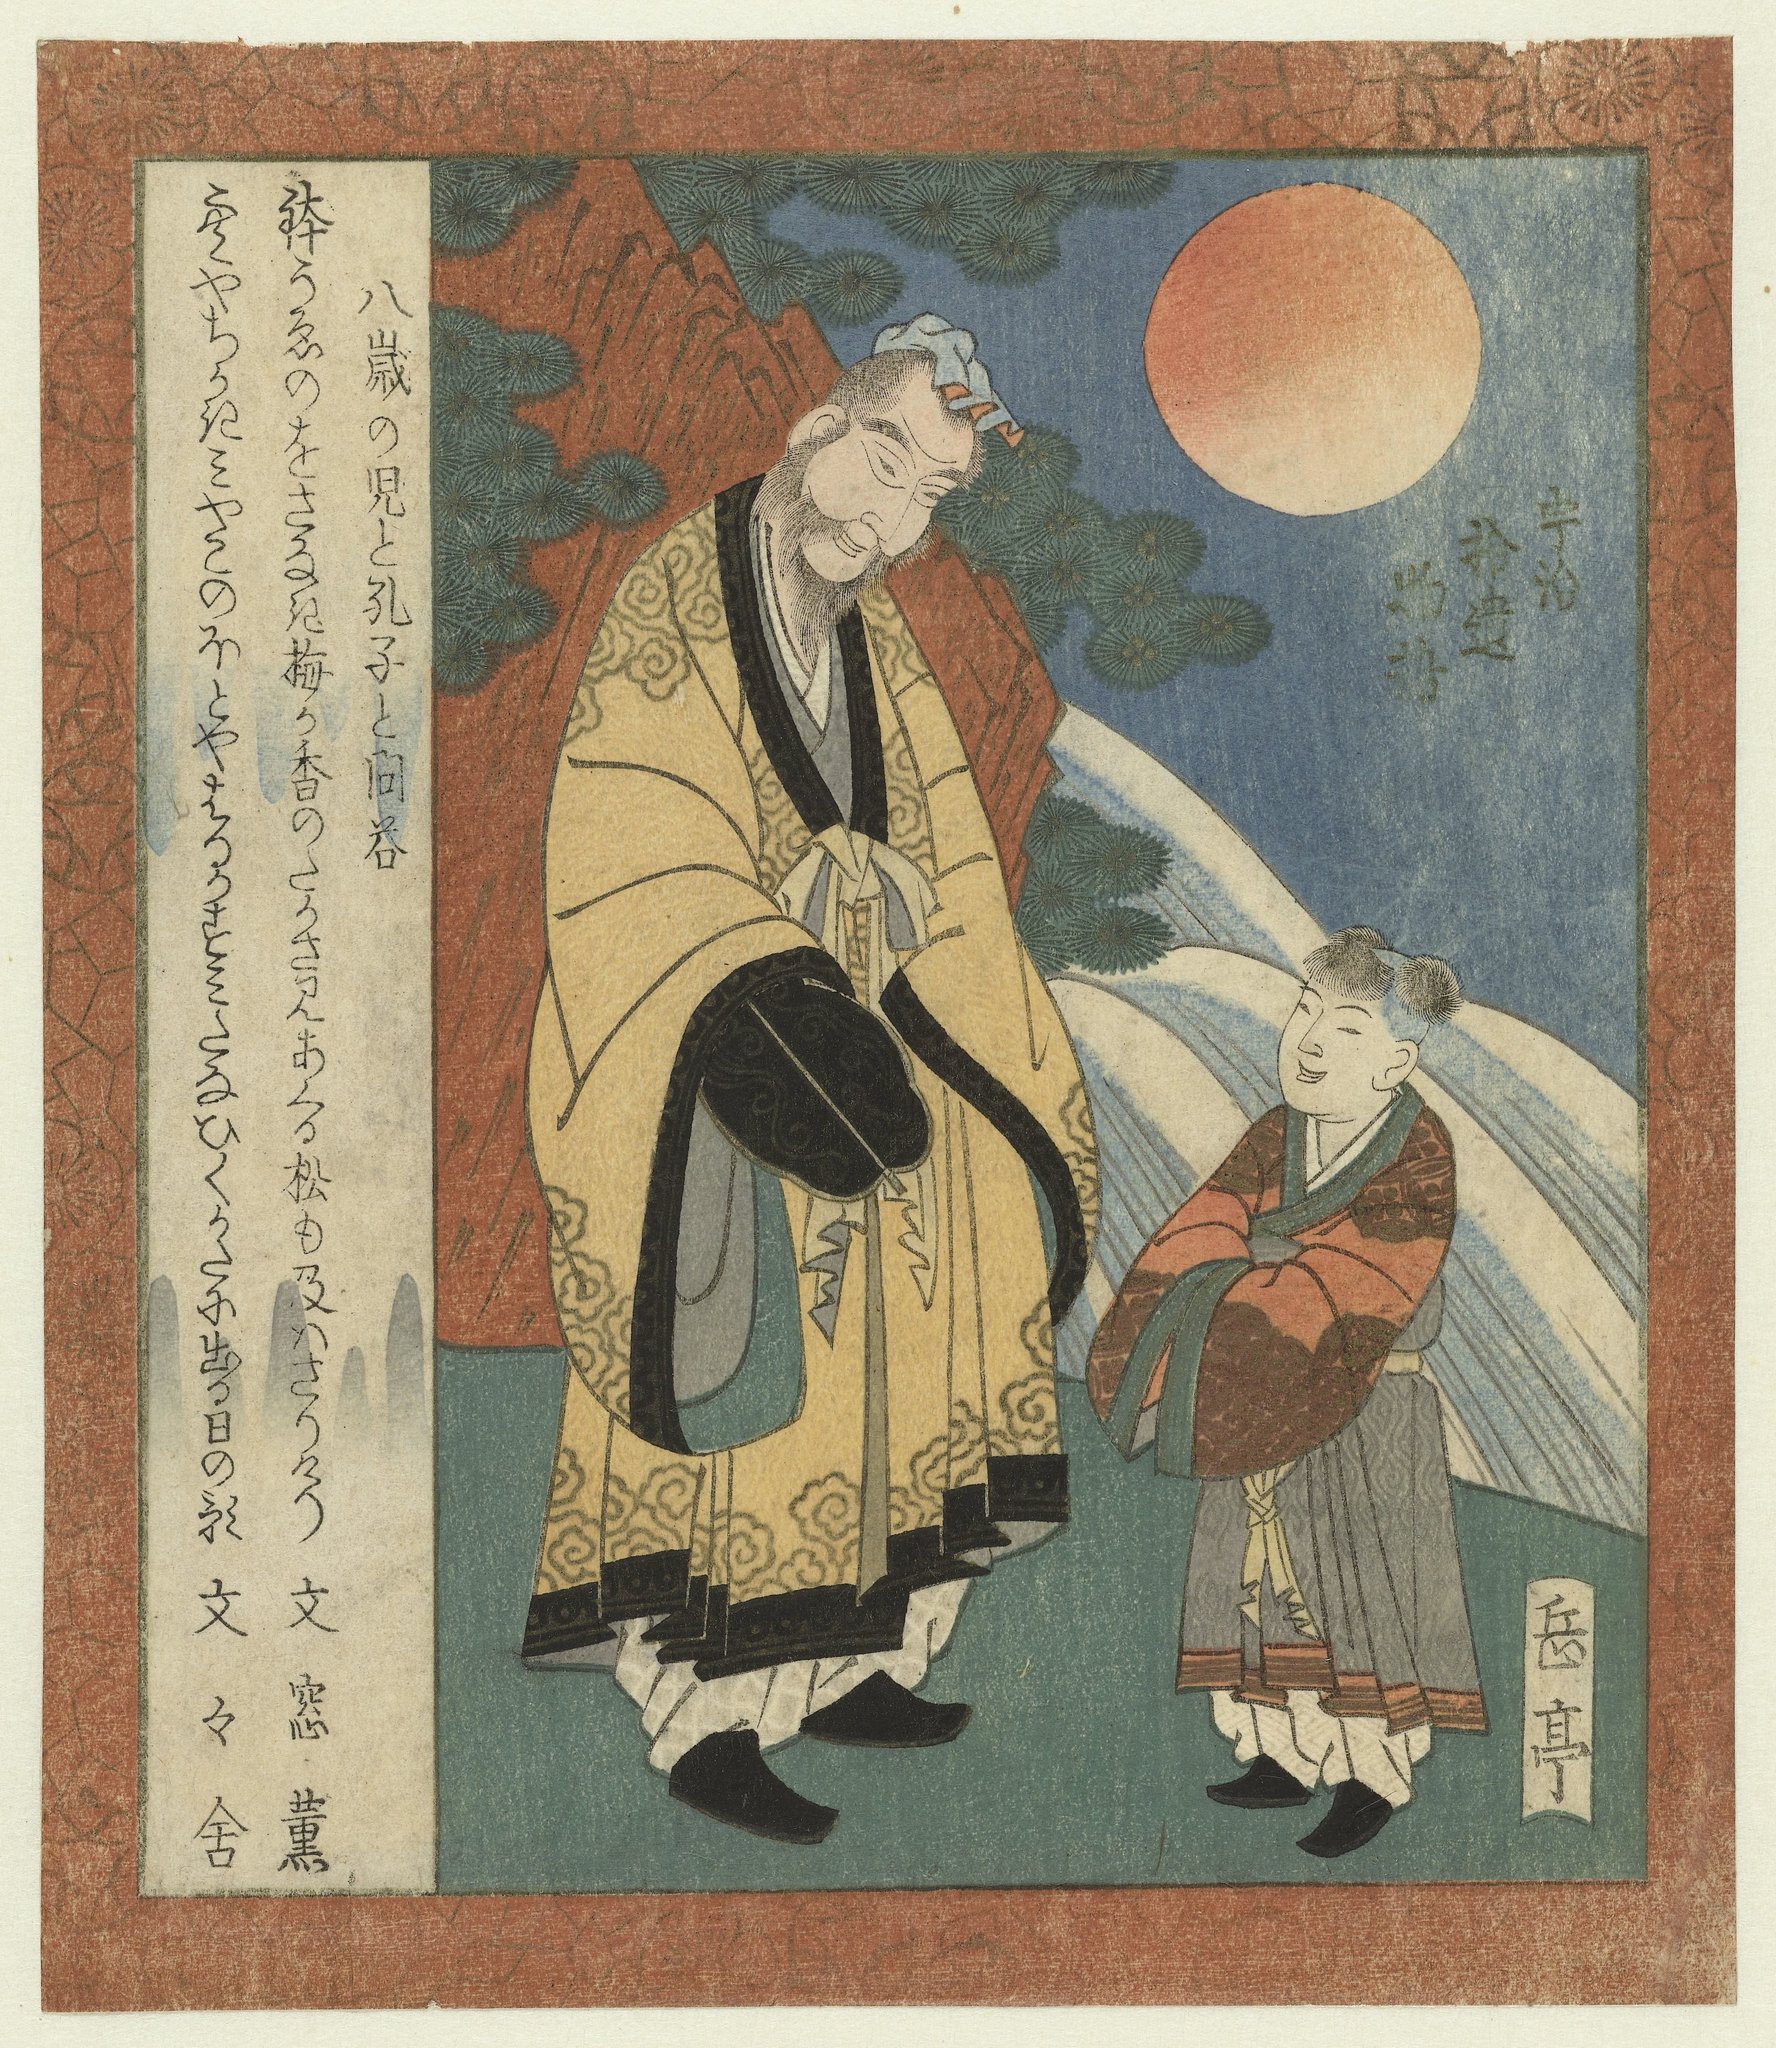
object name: surimono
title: Meningsverschil tussen een achtjarige jongen en Confucius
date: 1829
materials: paper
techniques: blind stamped, woodcut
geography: japan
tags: waterfall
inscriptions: collector's mark, verso, stamped: Lugt 2228, collector's mark, passe-partout, bottom left, printed: JABdH with a rooster.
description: De Chinese filosoof Confucius (Kôshi) in gesprek met een kleine jongen die voor hem staat. Achter hen een waterval en opkomende zon. Links rotsen en takken van een pijnboom. Met twee gedichten. Deze afbeelding verwijst naar het verhaal van het jongetje dat aan Confucius vroeg wat er verder weg was, de stad Lo Yang, of de plek waar de zon onder gaat. Nadat de wijsgeer hem het voor de hand liggende antwoord had gegeven, bracht het jongetje er tegenin dat je de plek waar de zon onder gaat kunt zien, maar de stad Lo Yang niet.